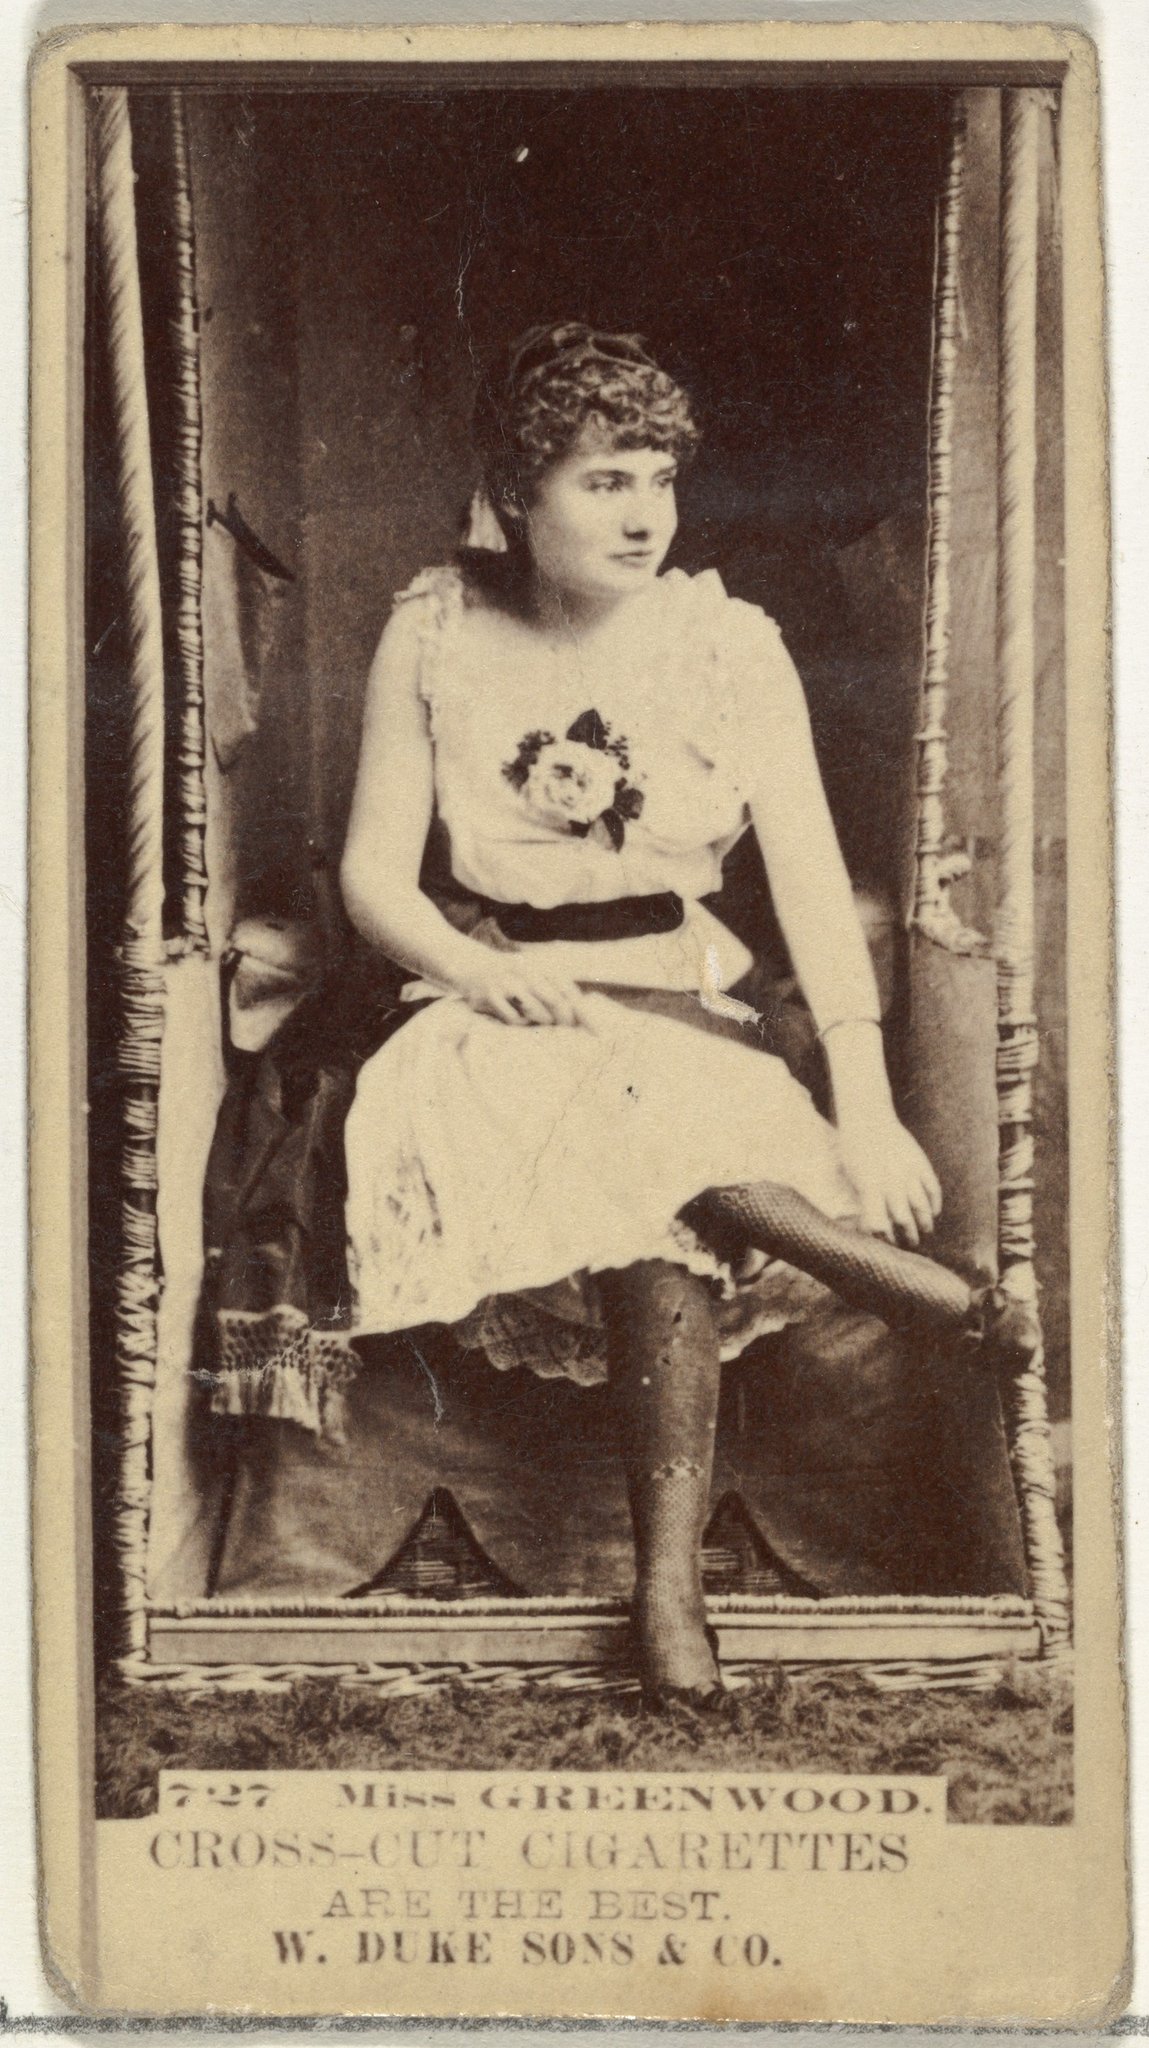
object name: photograph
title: Card Number 727, Miss Greenwood, from the Actors and Actresses series (N145-3) issued by Duke Sons & Co. to promote Cross Cut Cigarettes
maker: w. duke, sons & co.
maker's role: publisher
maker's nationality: american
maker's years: 1870-1920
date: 1880-1889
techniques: albumen silver print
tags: portraits,women,actresses